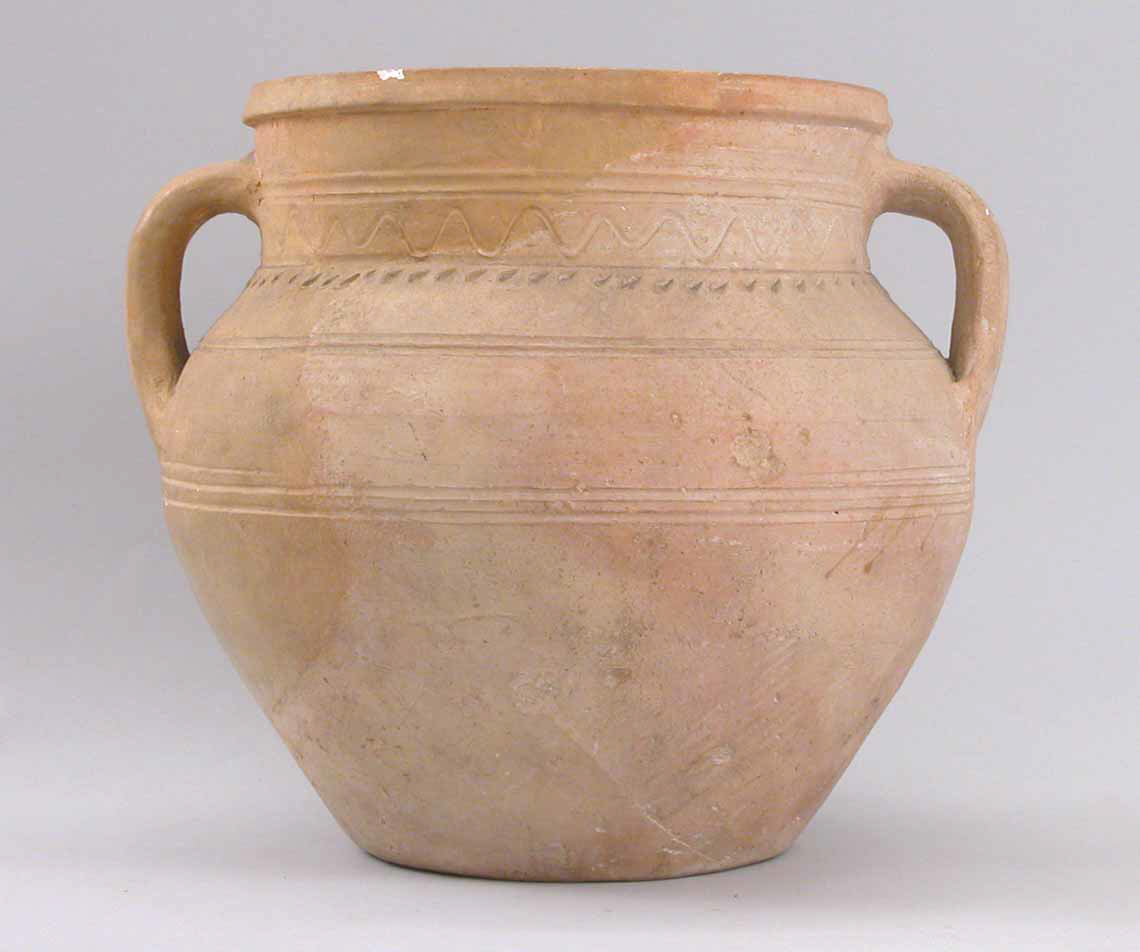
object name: jar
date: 701-800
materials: earthenware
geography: iran